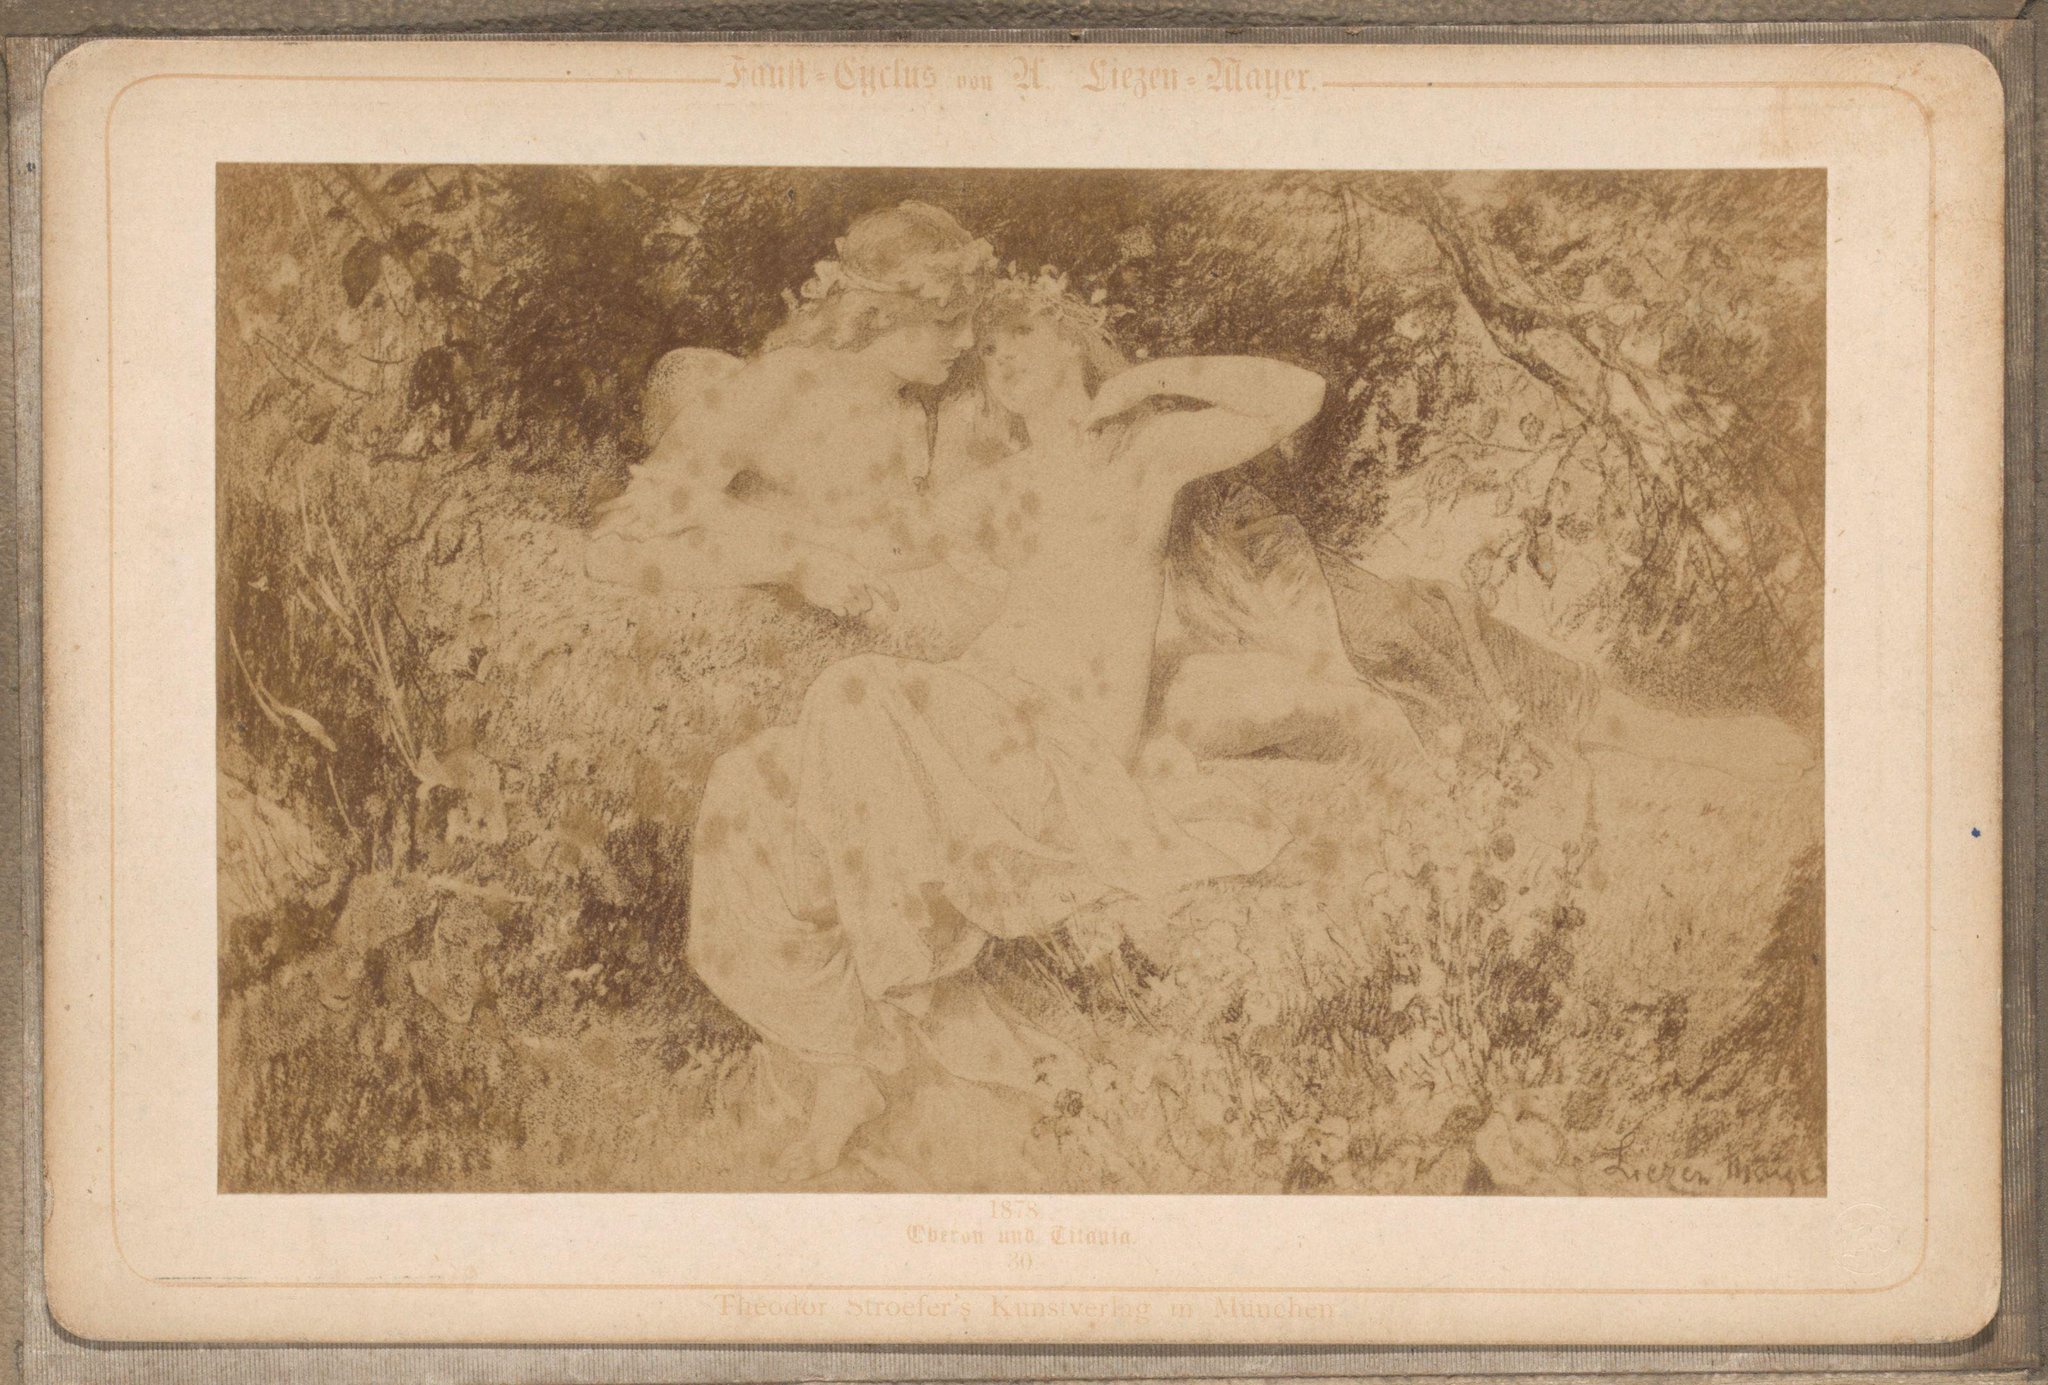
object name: photograph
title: Fotoreproductie van (vermoedelijk) een tekening getiteld 'Oberon en Titania'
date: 1878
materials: cardboard, paper, photographic support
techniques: albumen print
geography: munich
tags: faust, forest, wood, fairy, wedding anniversary celebration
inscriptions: check stamp: ‘TS’, number: ‘30’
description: Onderdeel van Album met 30 fotoreproducties van tekeningen van het Faust-verhaal van J.W. von Goethe.